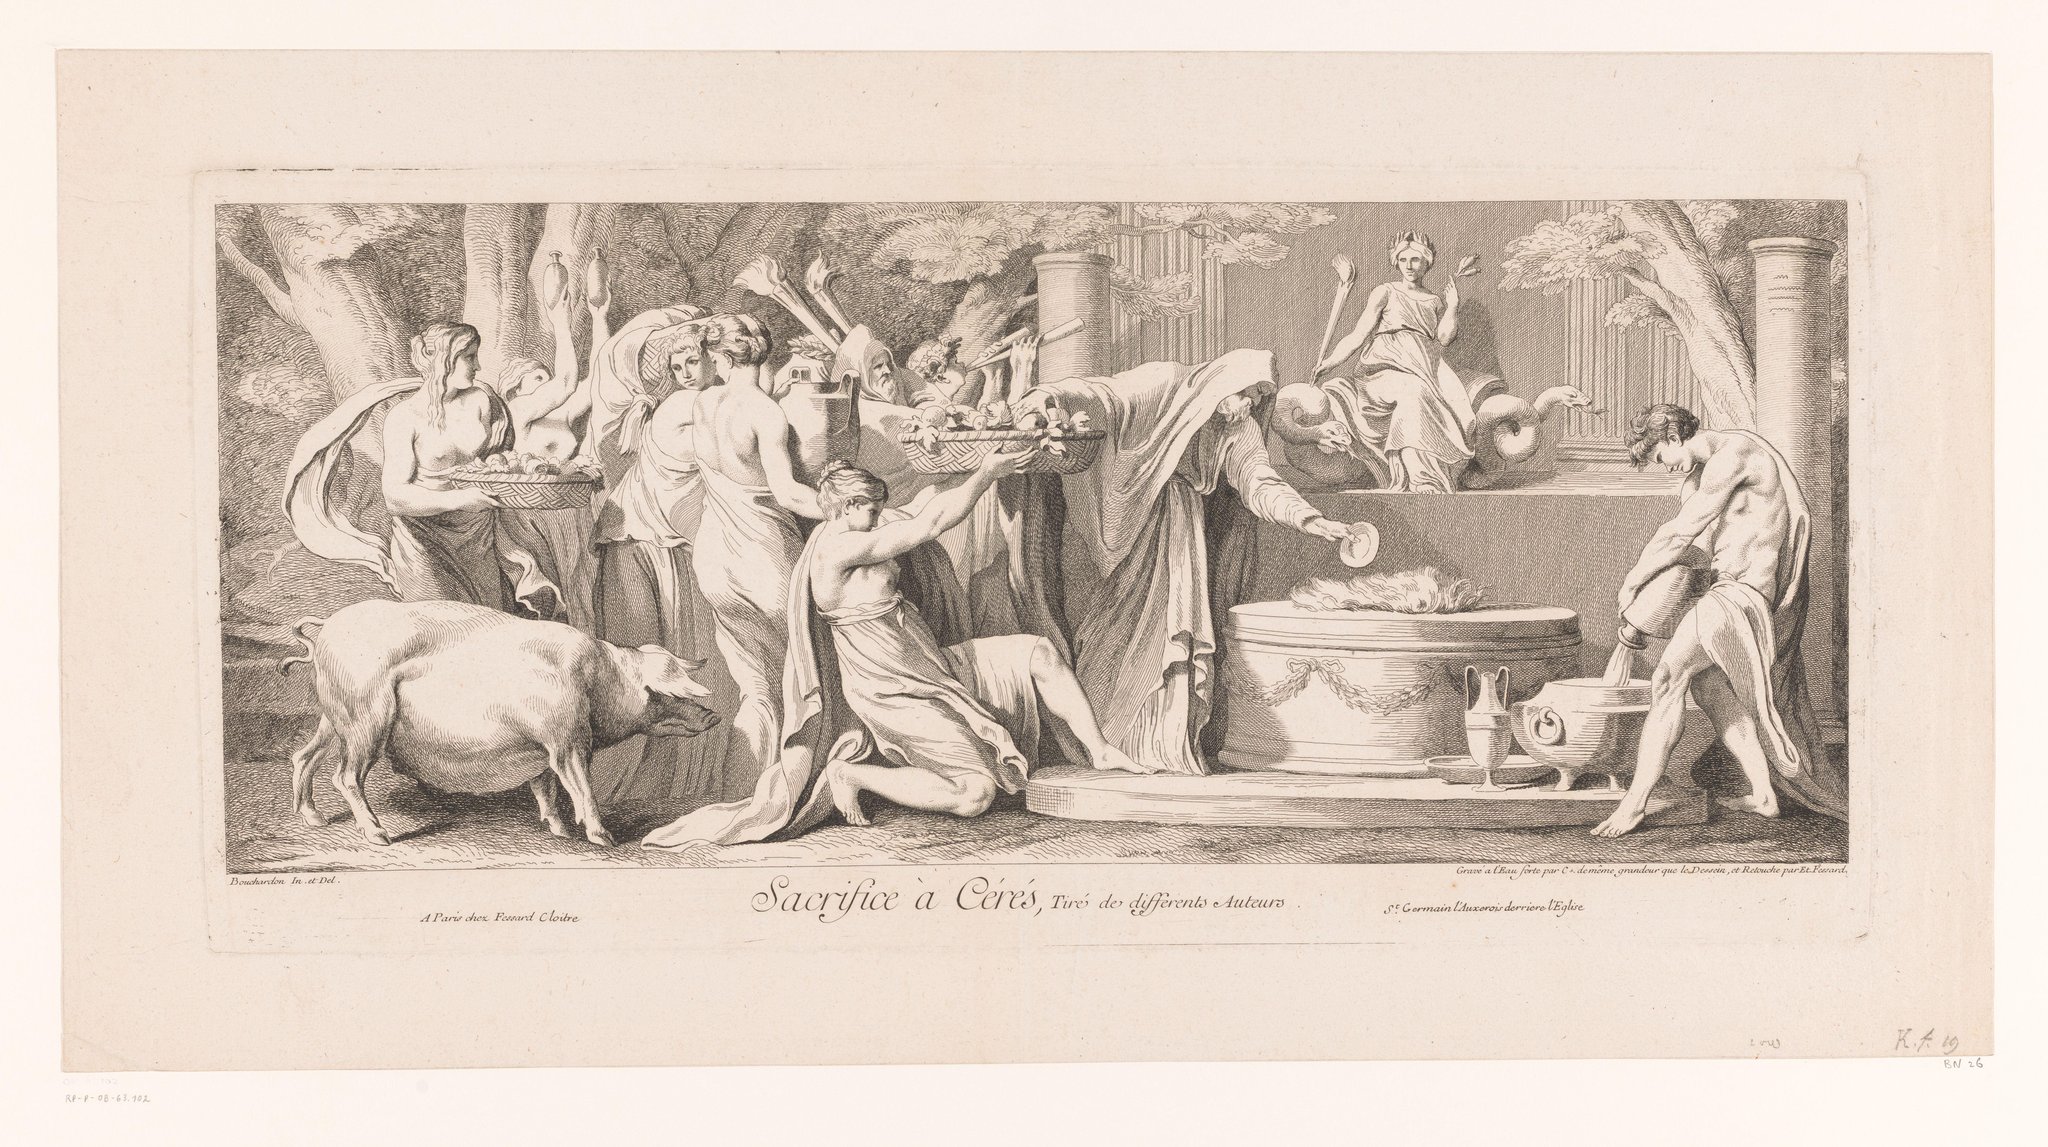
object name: print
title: Sacrifice à Cérés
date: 1730-1740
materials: paper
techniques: engraving, etching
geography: paris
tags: (story of) ceres (demeter), pig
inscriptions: watermark, collector's mark: Lugt 240